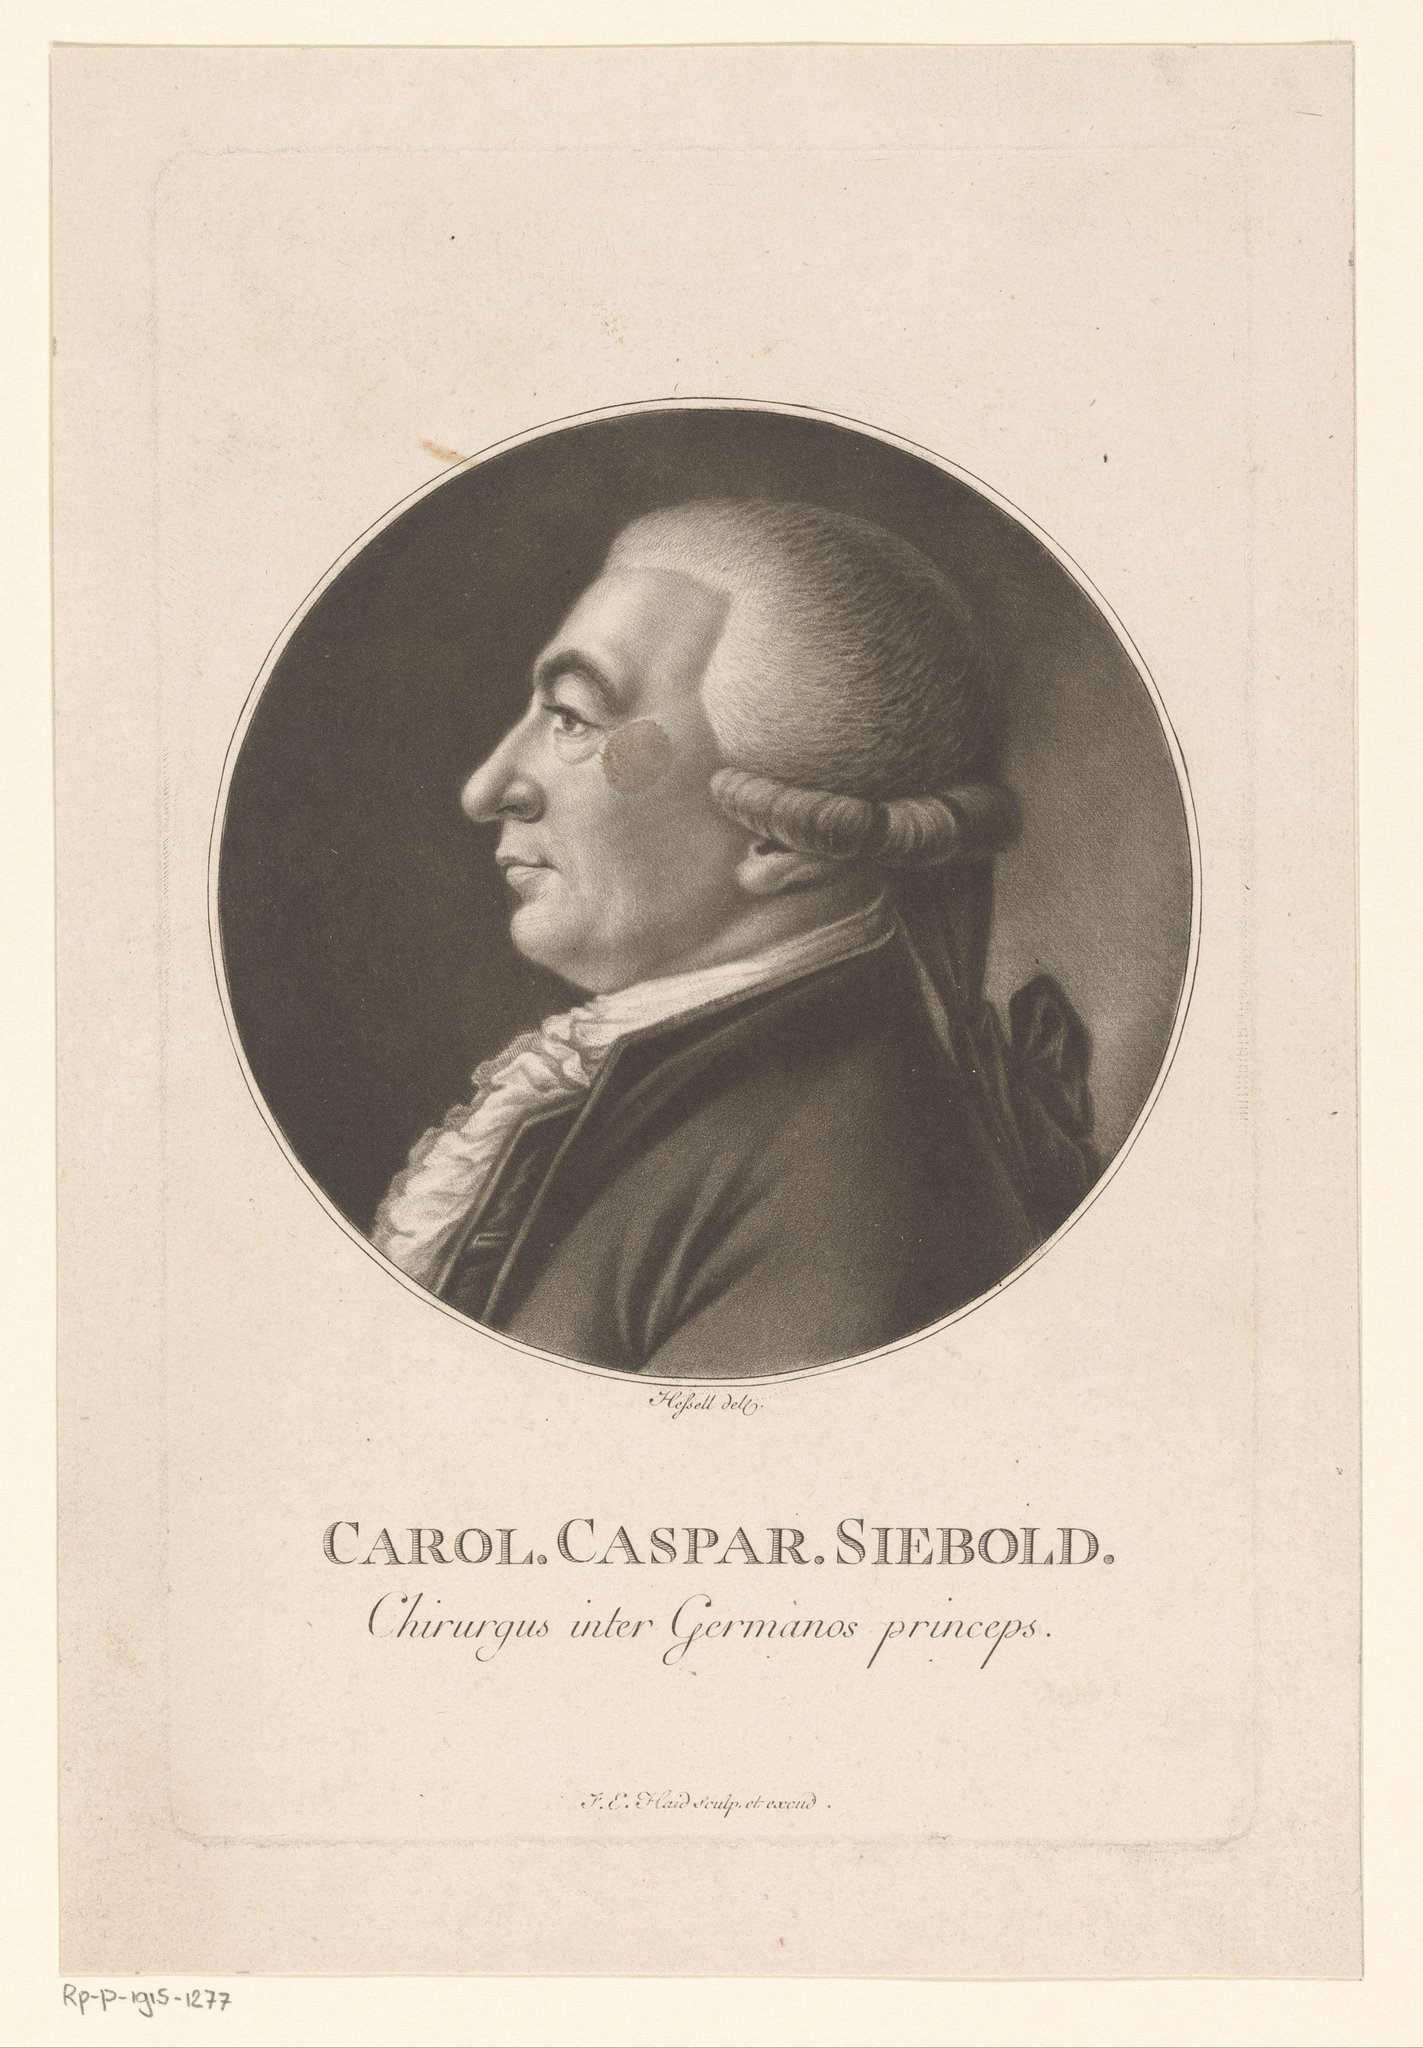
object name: print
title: Portret van Carl Caspar Siebold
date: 1749-1807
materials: paper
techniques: mezzotint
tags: historical persons, physician, doctor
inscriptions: collector's mark: Lugt 2228